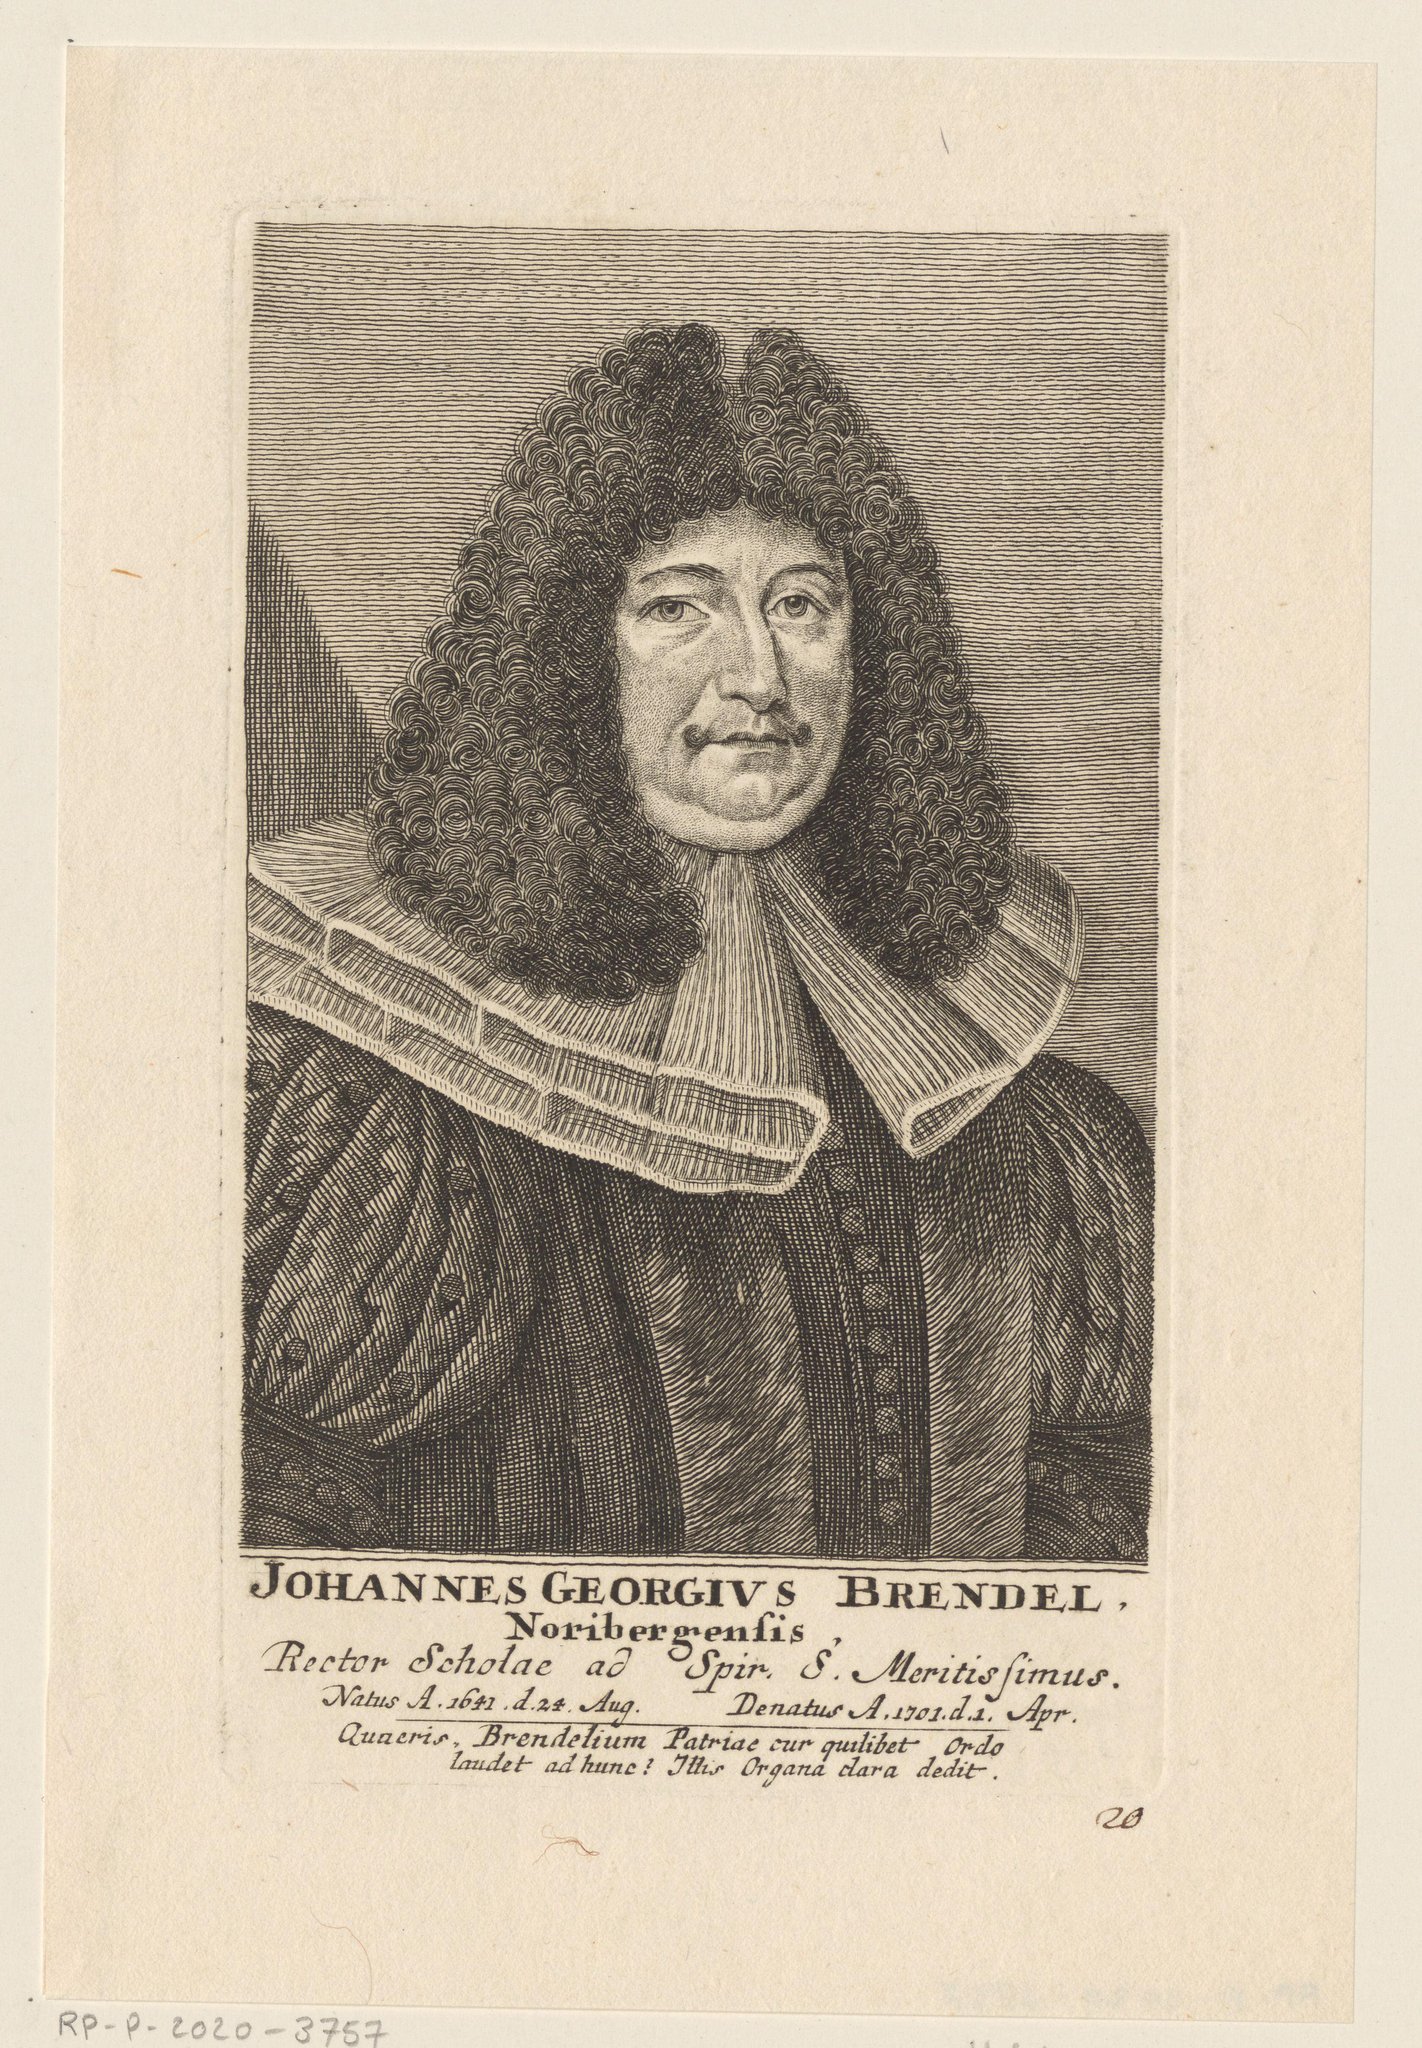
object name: print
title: Portret van Johann Georg Brendel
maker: Anonymous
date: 1701-1749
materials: paper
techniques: engraving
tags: historical persons